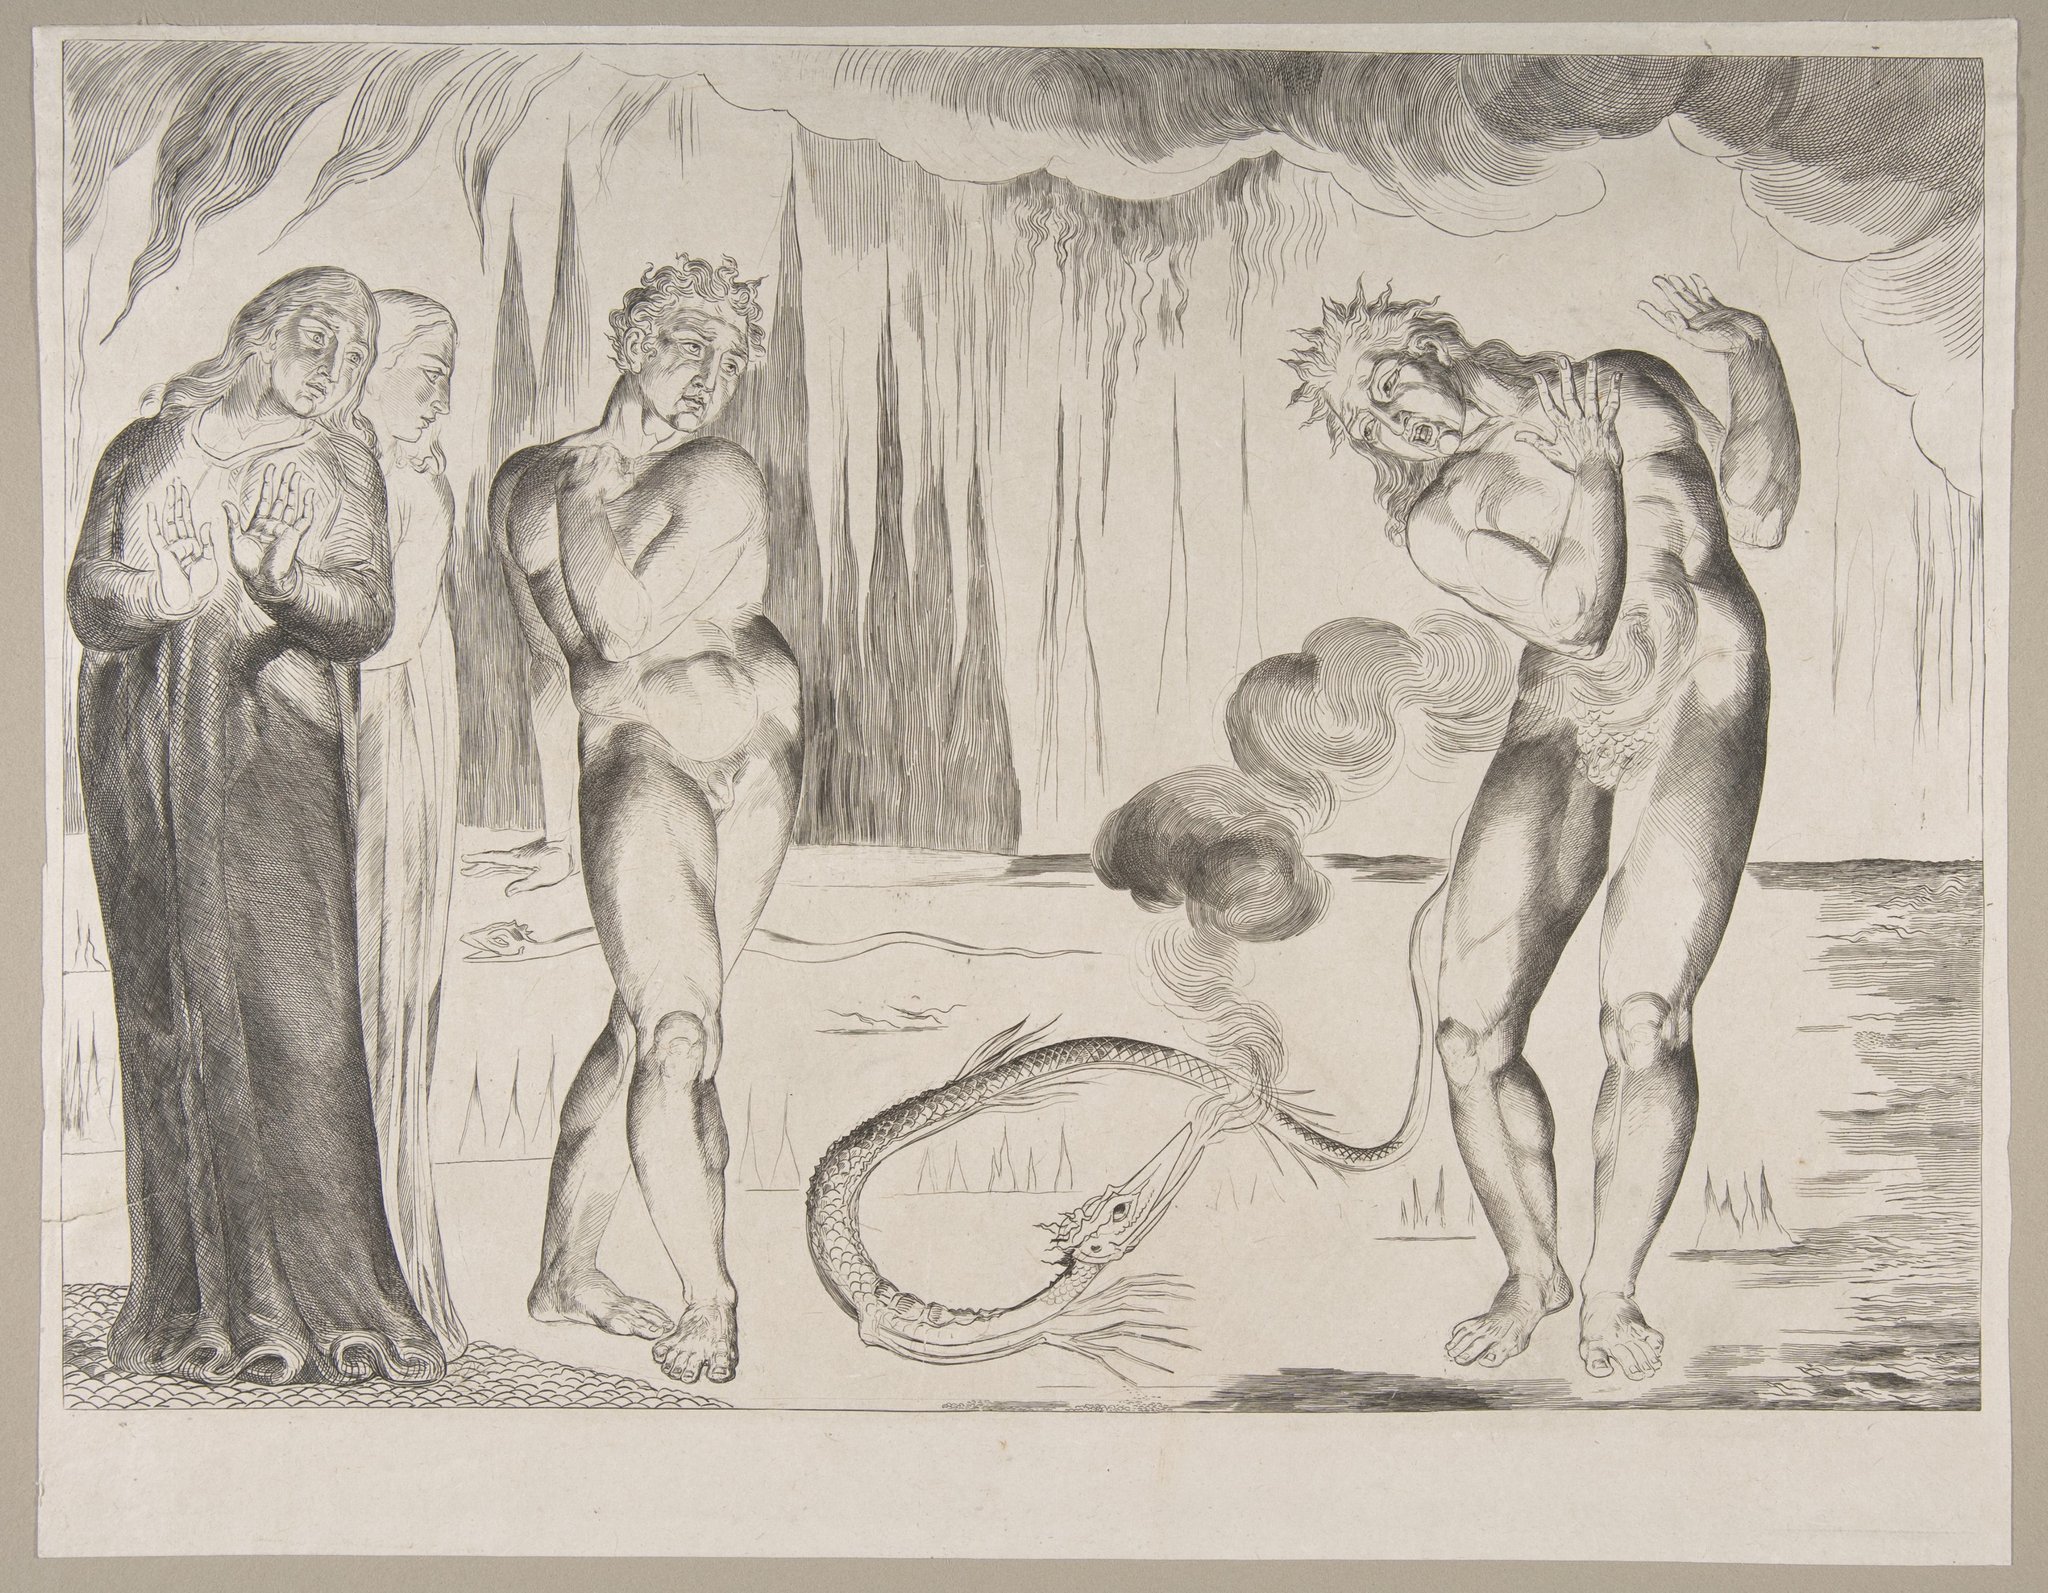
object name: print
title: The Circle of the Thieves; Buoso Donati Attacked by the Serpent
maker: william blake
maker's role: artist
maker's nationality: british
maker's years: 1757-1827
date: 1825-1827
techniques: engraving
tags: male nudes,women,snakes